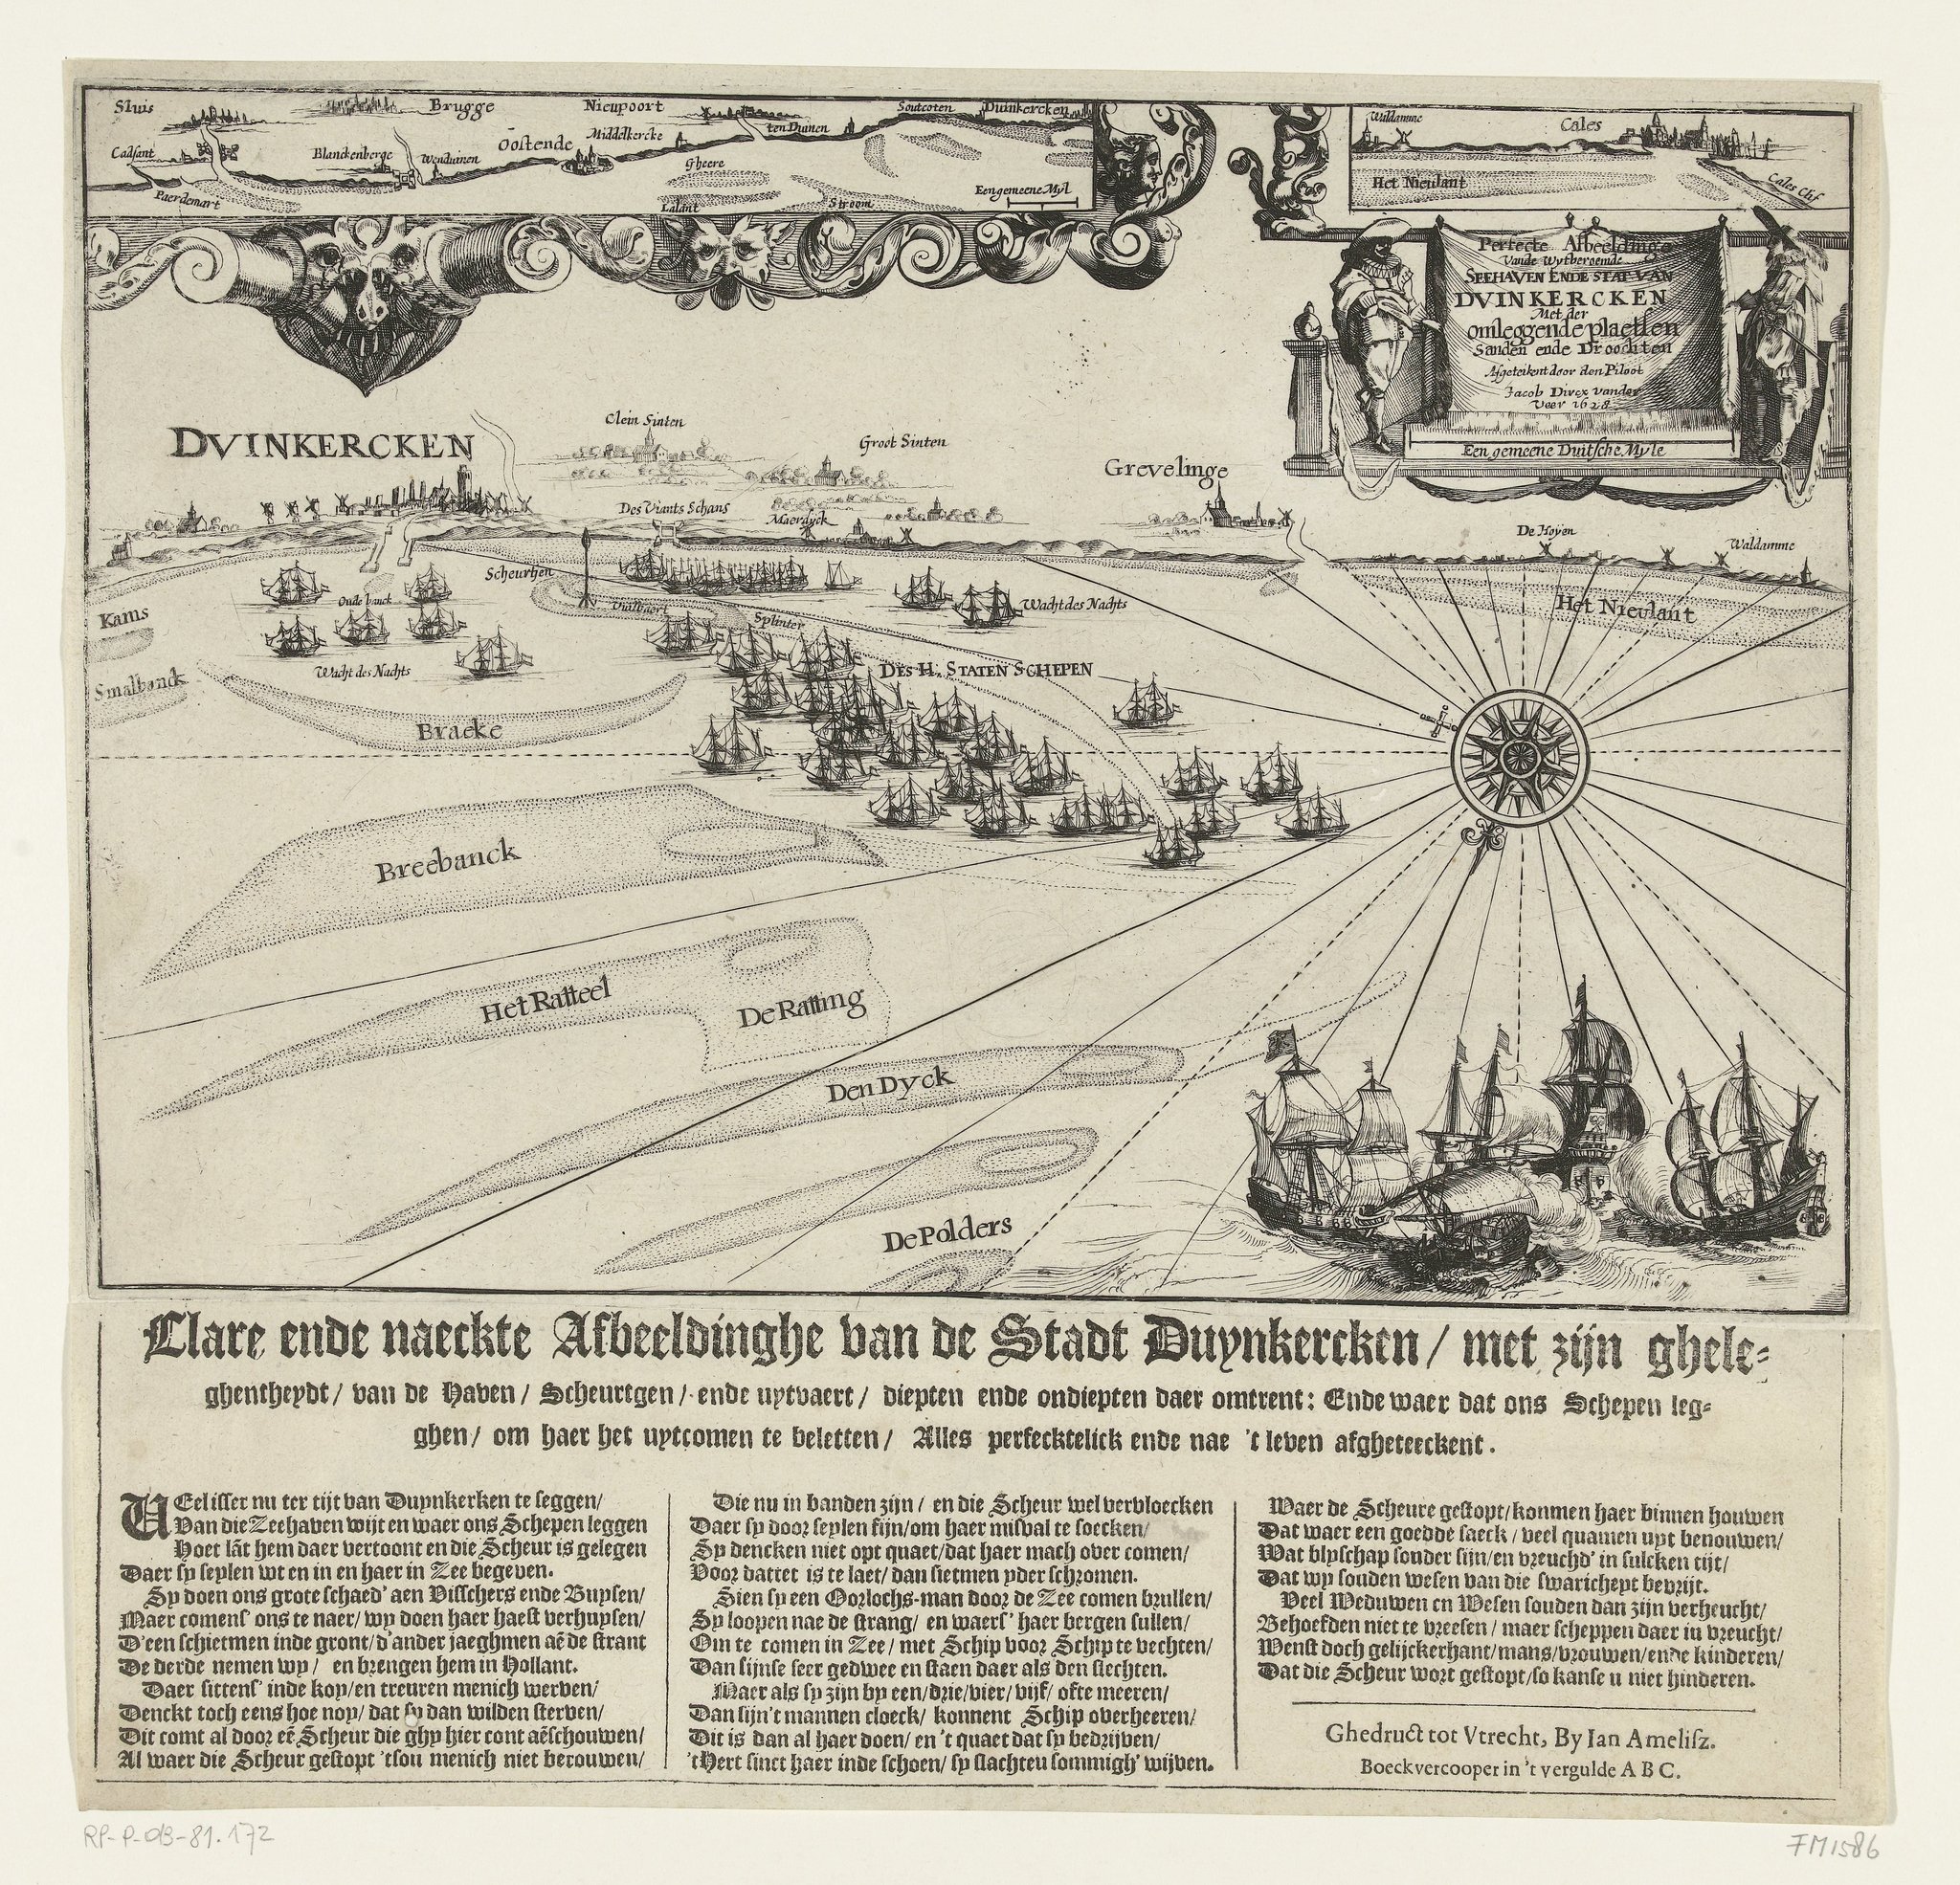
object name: print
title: Clare ende naeckte Afbeeldinghe van de Stadt Duynkercken / met zijn gheleghentheydt / van de haven / scheurtgen / ende uytvaert / diepten ende ondiepten daer omtrent: Ende waer dat ons Schepen legghen / om haer het uytcomen te beletten / Alles perfecktelick ende nae 't leven afgheteeckent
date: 1628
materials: paper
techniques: etching, letterpress printing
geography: northern netherlands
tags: pirate, corsair, buccaneer, battle (+ naval force)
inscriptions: date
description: Het Noord-Franse en Vlaamse kustgebied tussen Duinkerken en Grevelingen met schepen van de Staatse vloot liggend voor Duinkerken om het uitvaren van zeerovers te beletten, 1628. Op de voorgrond een gevecht tussen enkele oorlogsschepen. Bovenaan twee inzetten met detailkaarten. Onder de plaat gedrukt een tekst in 3 kolommen.